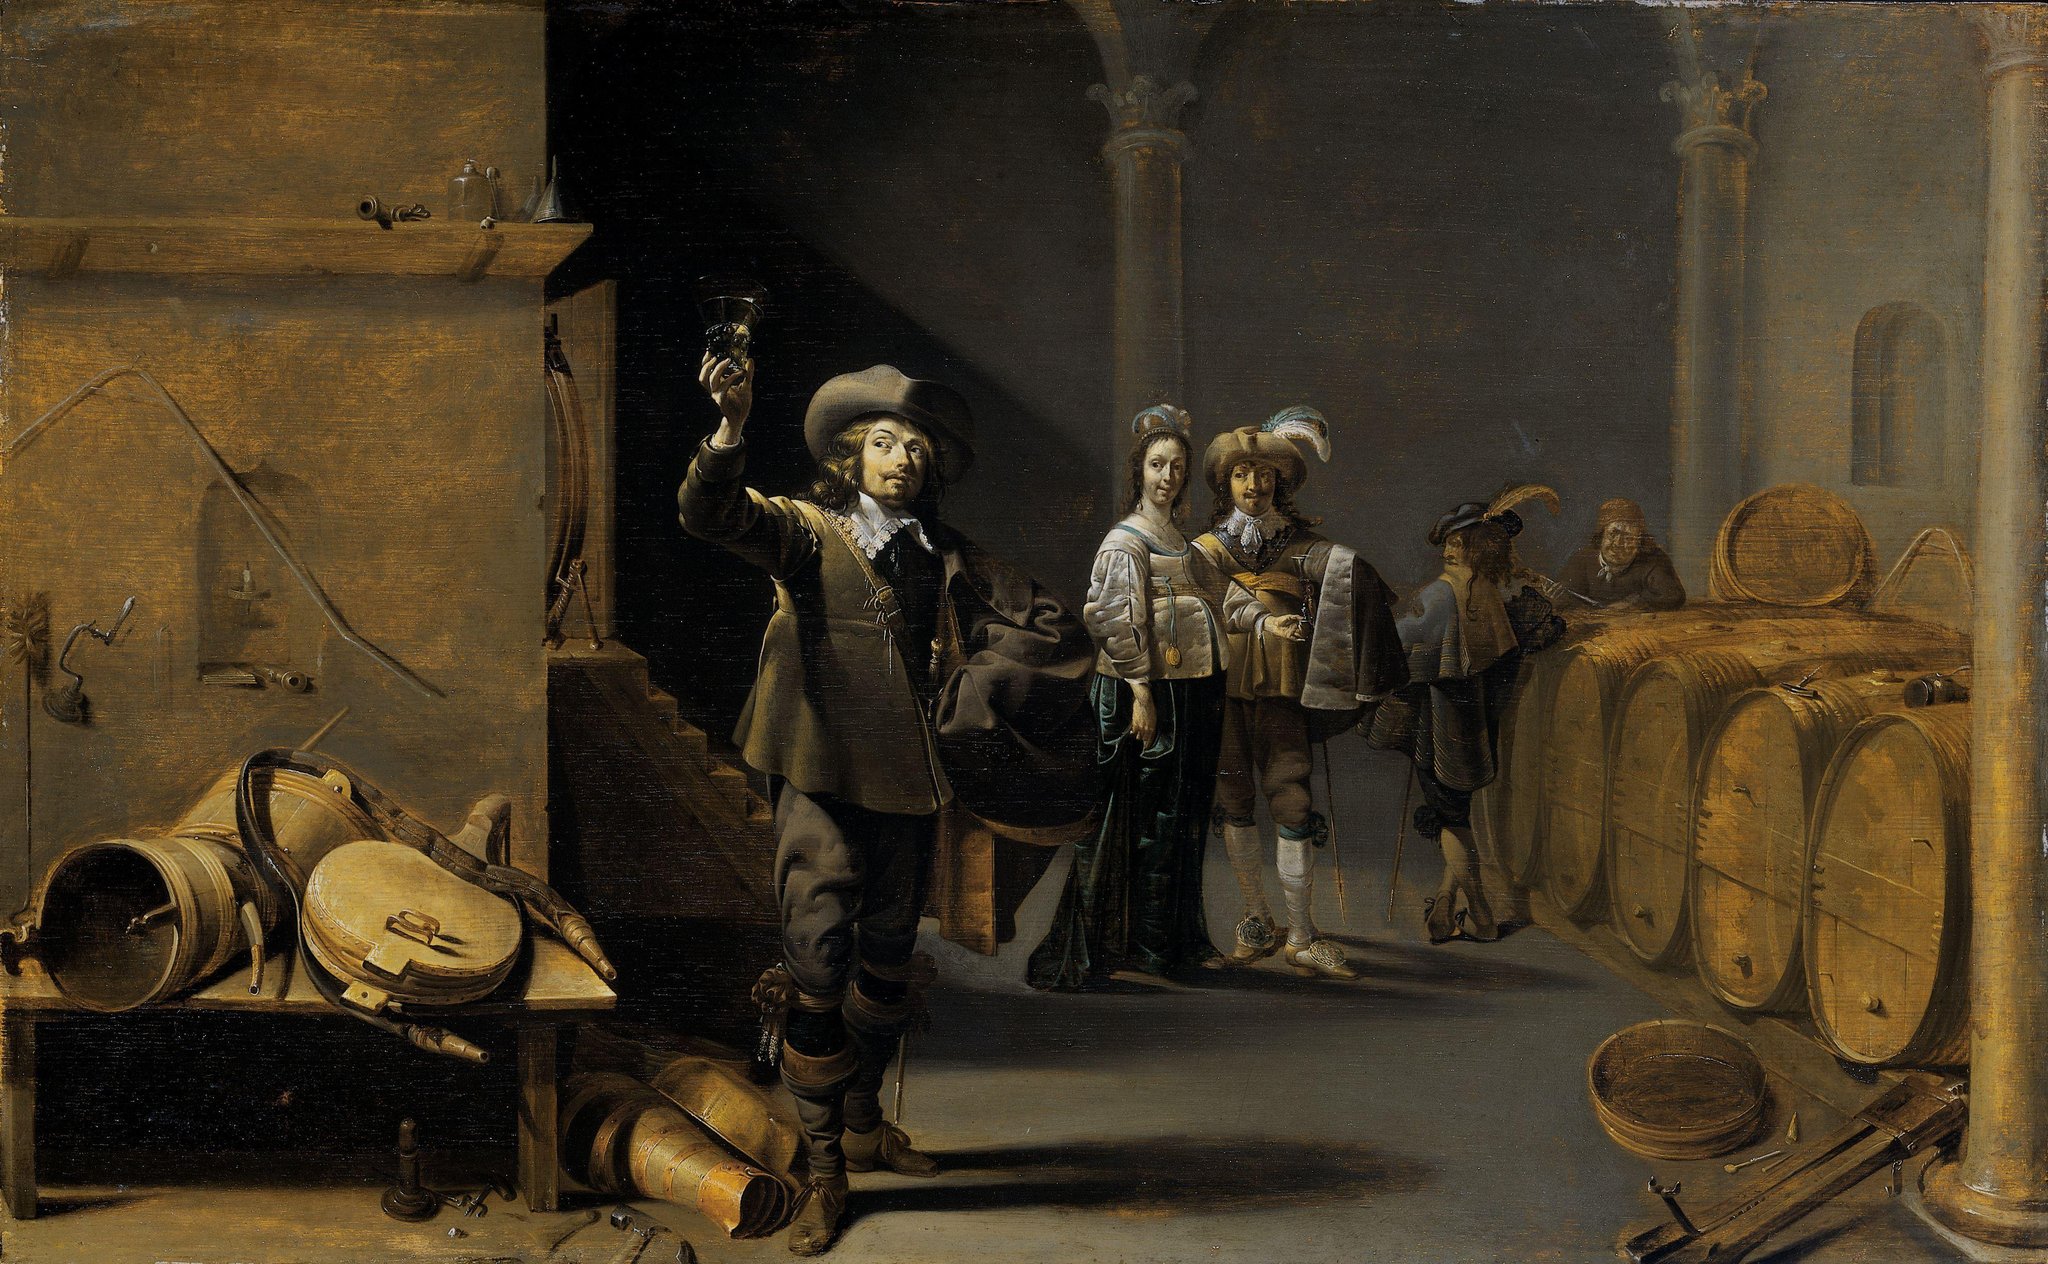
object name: painting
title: The Wine Connoisseurs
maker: jacob duck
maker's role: draughtsman, painter, print maker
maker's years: 1600-1667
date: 1640-1642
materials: oil, panel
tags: wine-cellar, wine ~ alcoholic drinks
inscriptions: signature, lower left: ‘I. Dvck’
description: De wijnproevers. In een wijnkelder houdt een man een glas met wijn tegen het licht. Rechts een rij wijnvaten, op de achtergrond kijken een man en een vrouw toe. Links op een houten bank liggen allerlei soorten gereedschap: emmers, slangen, blaasbalg etc.